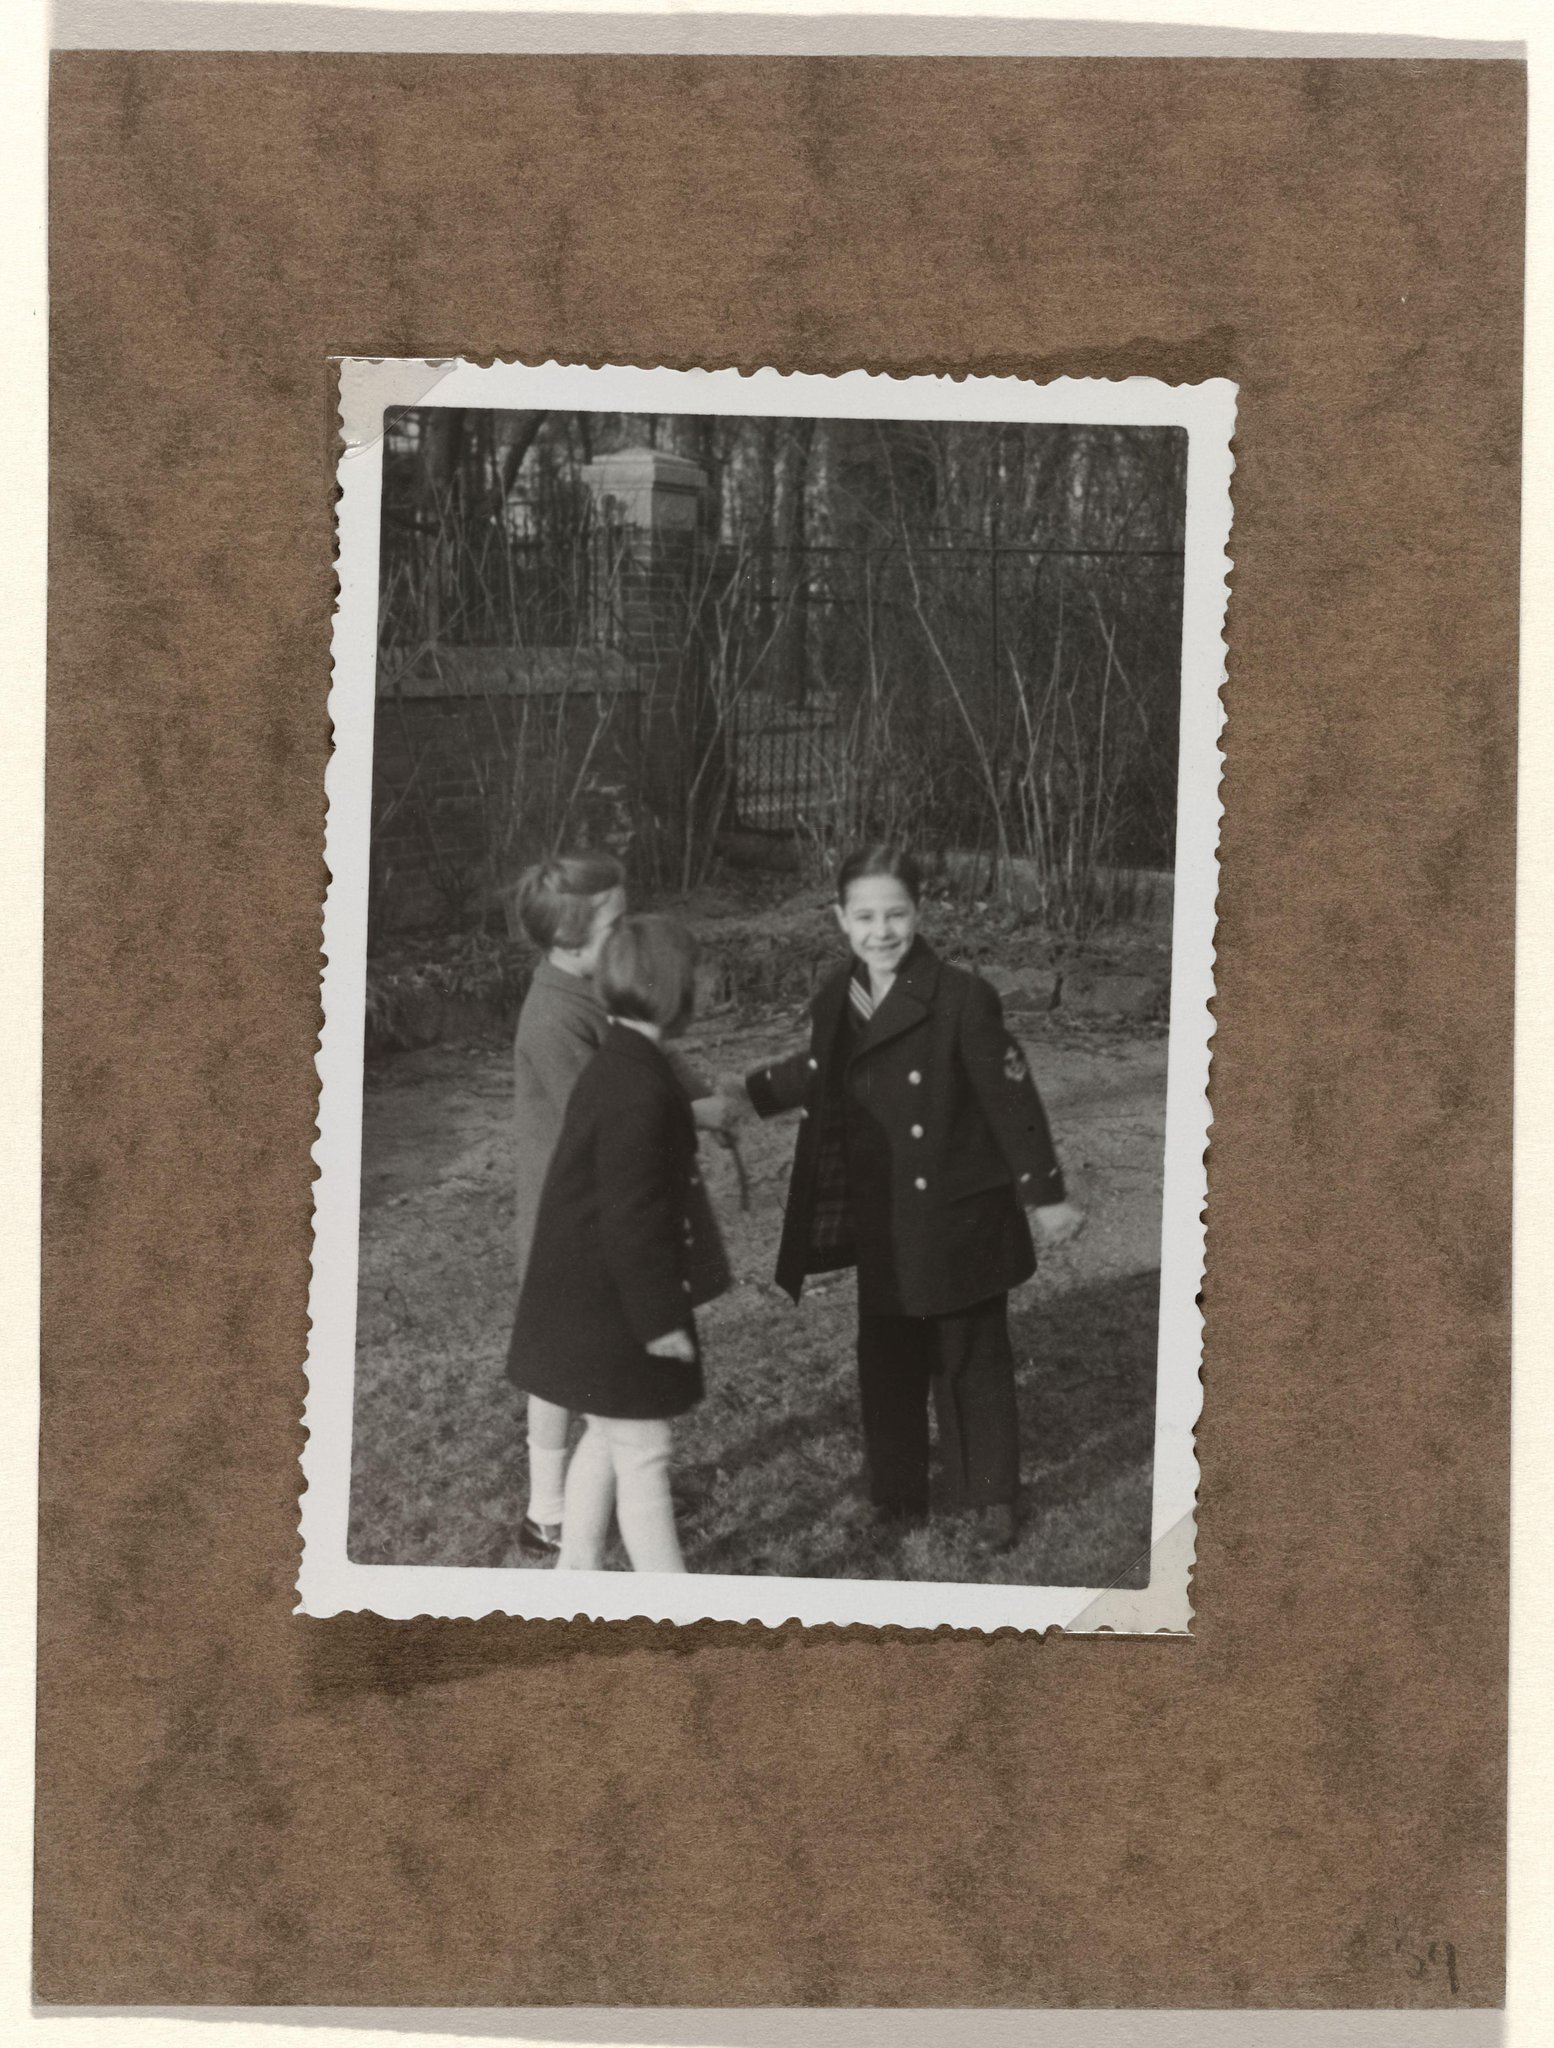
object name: photograph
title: Isabel Wachenheimer, Erica en Hansl in de tuin van de woning van Willy Moos in Hamburg, Bellevue 62, in maart-april 1935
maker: Anonymous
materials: photographic support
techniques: gelatin silver print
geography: hamburg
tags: leiden, isabel wachenheimer-elon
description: Dit object is onderdeel van de nalatenschap van Isabel Elon-Wachenheimer (1928-2010). Tot haar overlijden behoorde het samen met de andere objecten uit de nalatenschap tot haar privédomein van Isabel Wachenheimer. In die particuliere context zijn deze objecten tezamen en individueel aandenkens - aan de jeugd, ouders en familie van Isabel Wachenheimer vóór en tijdens de Shoah en aan haar leven na de Tweede Wereldoorlog. Isabel Wachenheimer, die van juni 1943 tot mei 1945 gevangen zat in Kamp Westerbork, Theresienstadt, Auschwitz, Lenzing a/d Oberdonau (een buitenkamp van Mauthausen), overleefde de Shoah. Haar ouders – Eugène Wachenheimer en Else Wachenheimer-Moos - werden op 14 oktober 1944 in Auschwitz-Birkenau vermoord.